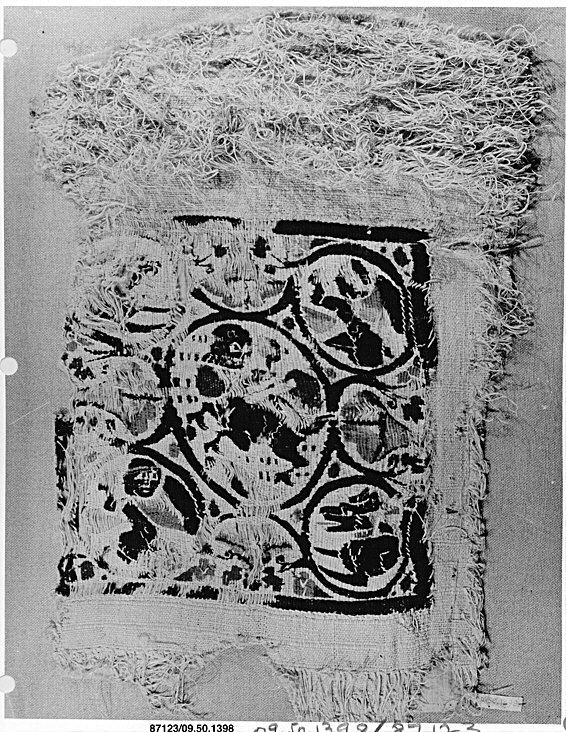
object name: textile fragment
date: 301-500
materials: linen, wool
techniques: weave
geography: egypt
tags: animals,men